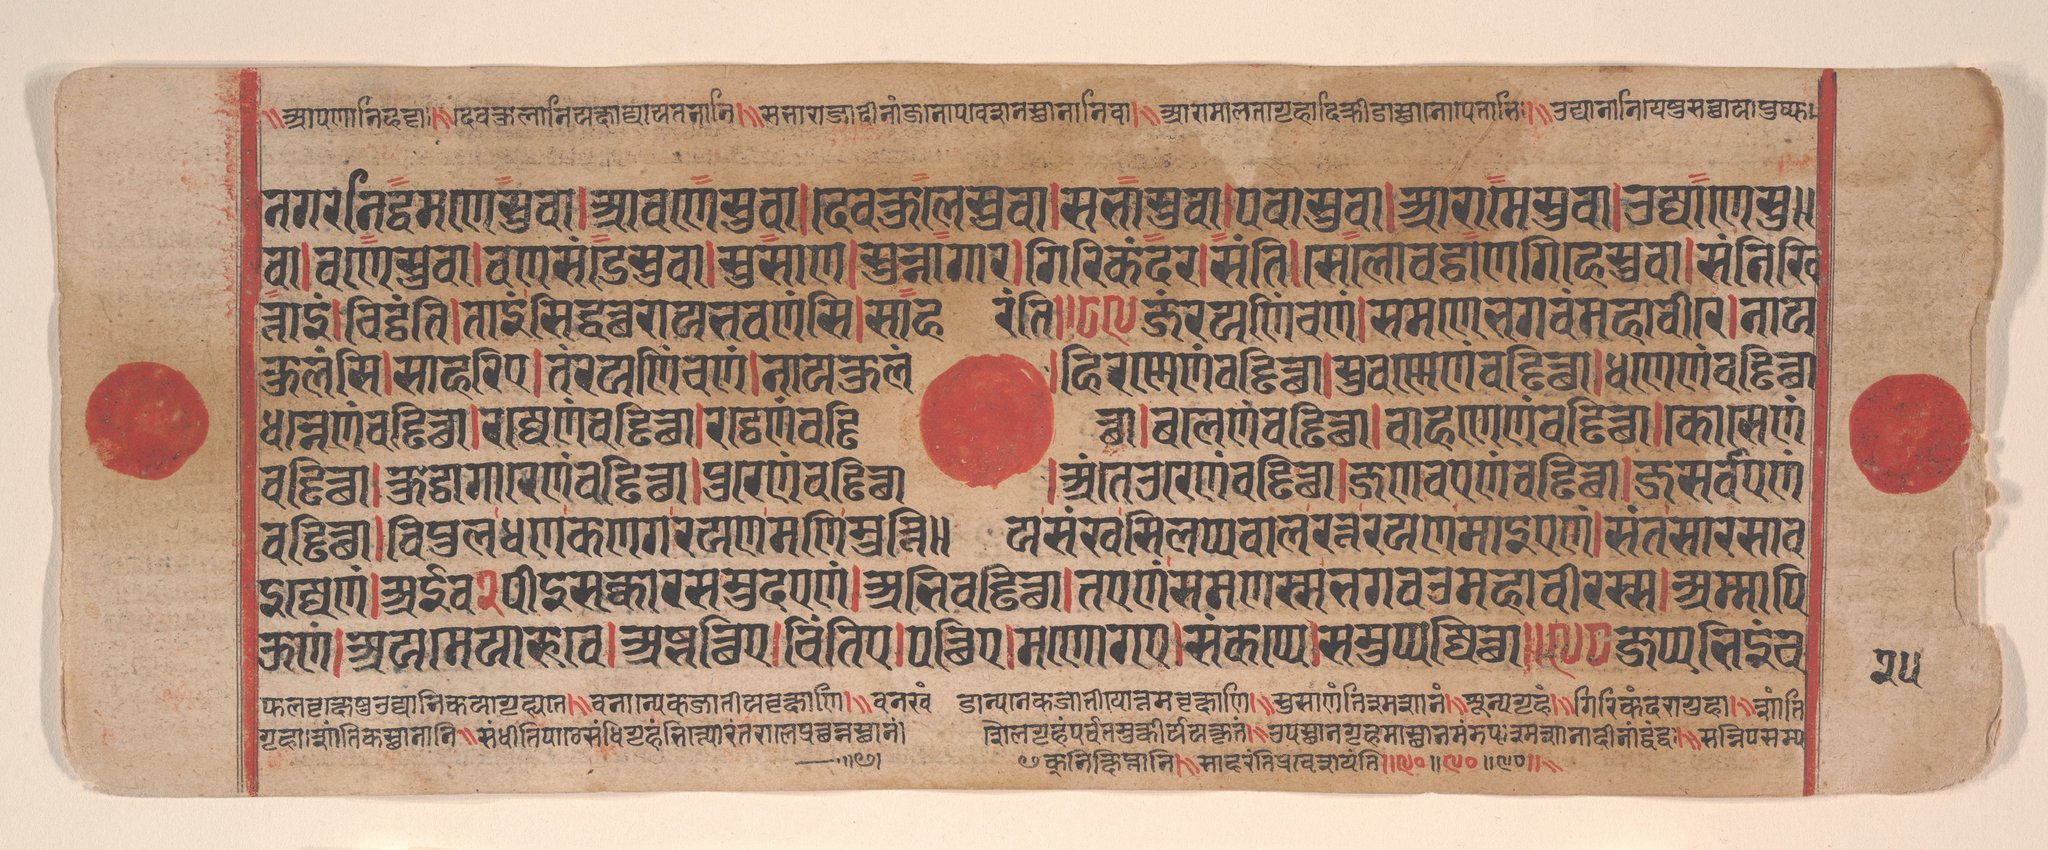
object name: folio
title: Leaf from a Kalpa Sutra (Jain Book of Rituals)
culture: indian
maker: bhadrabahu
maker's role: artist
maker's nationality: indian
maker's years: 356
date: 1401-1500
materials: gold, ink, paper, watercolor